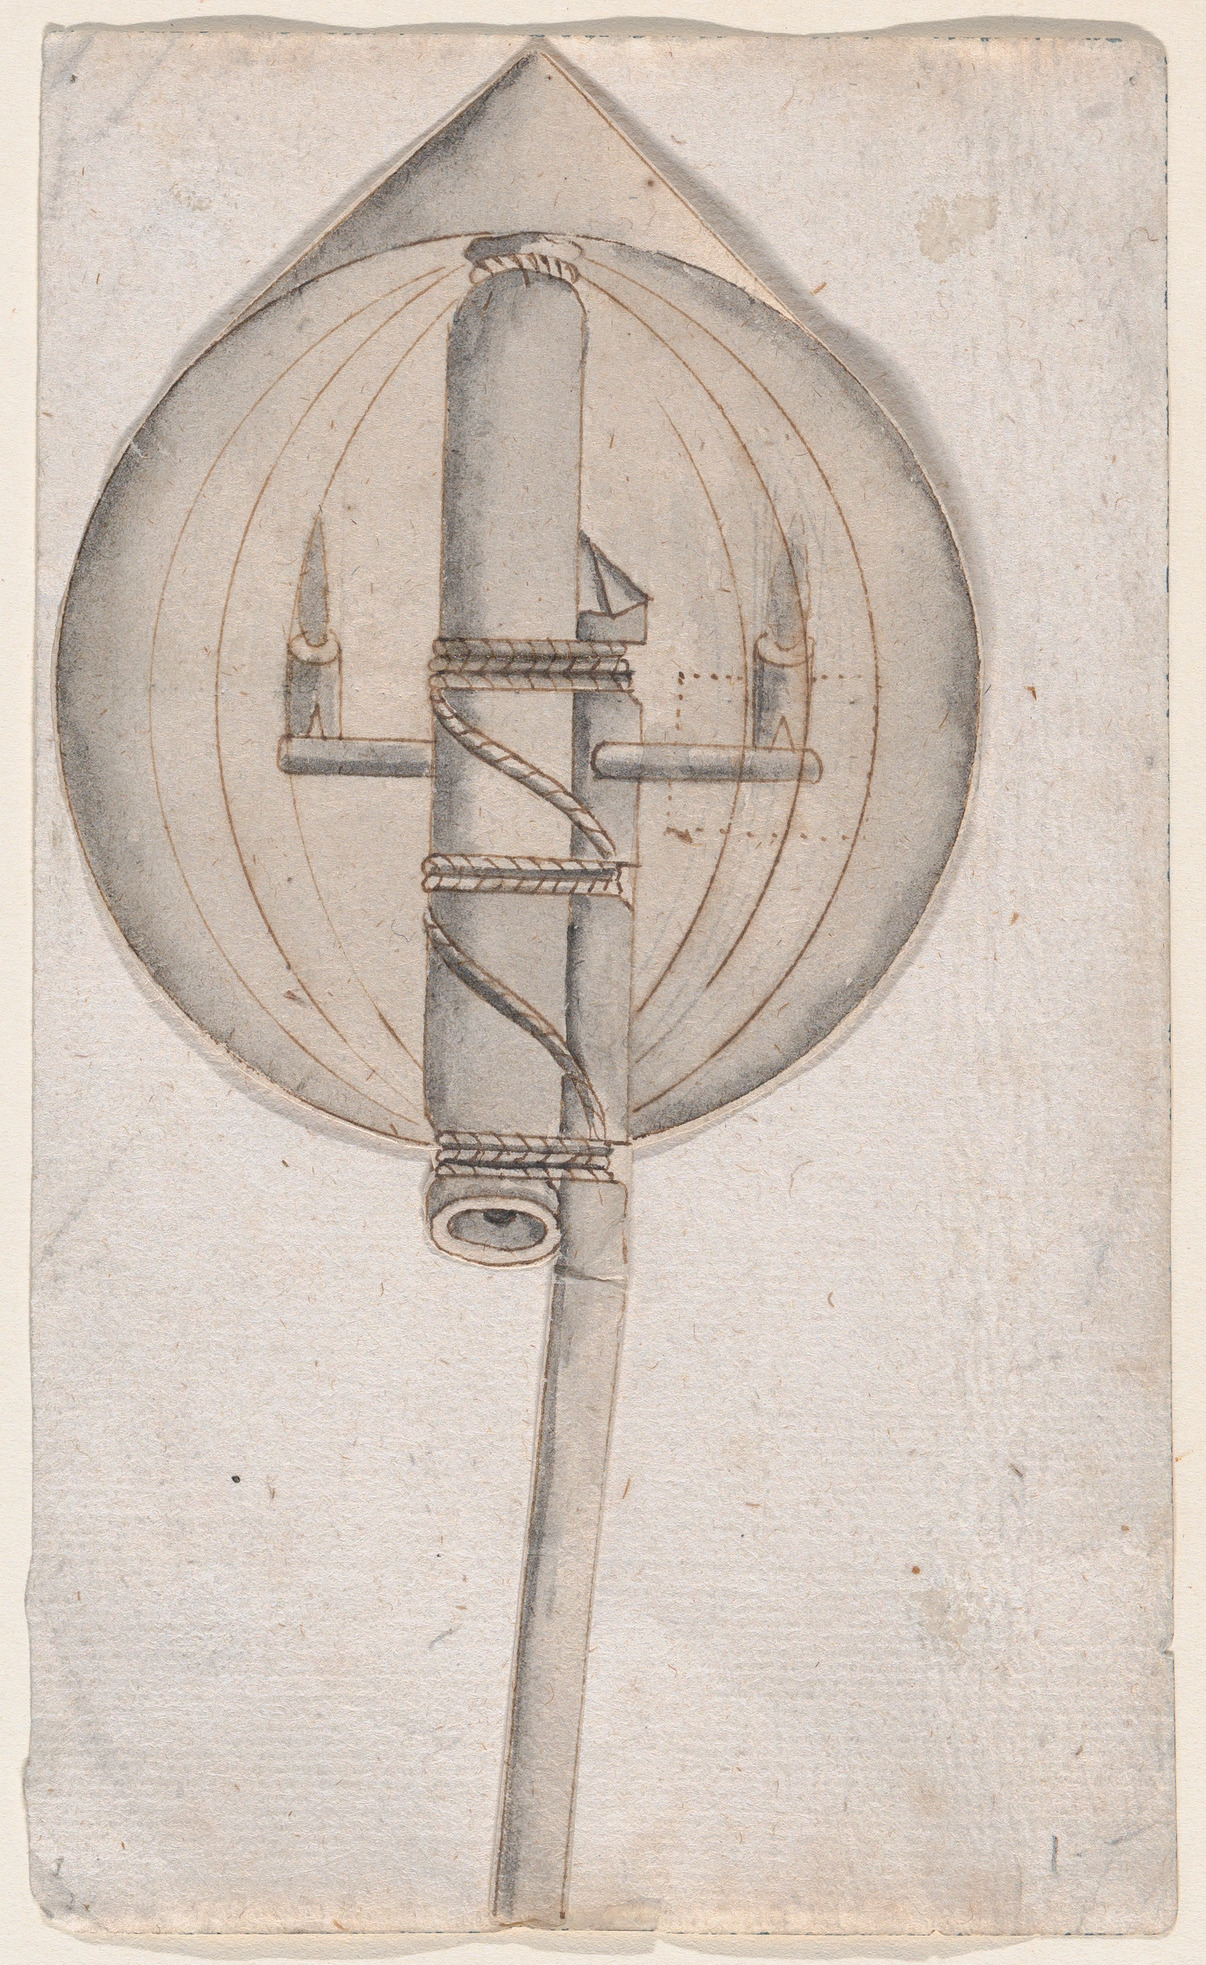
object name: drawing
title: Design of fireworks: the rocket in its propelling capsule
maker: anonymous, italian, 17th century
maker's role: artist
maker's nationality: italian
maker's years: 1600-1700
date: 1650-1750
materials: graphite, ink, drawing material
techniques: brush, pen, wash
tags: fireworks